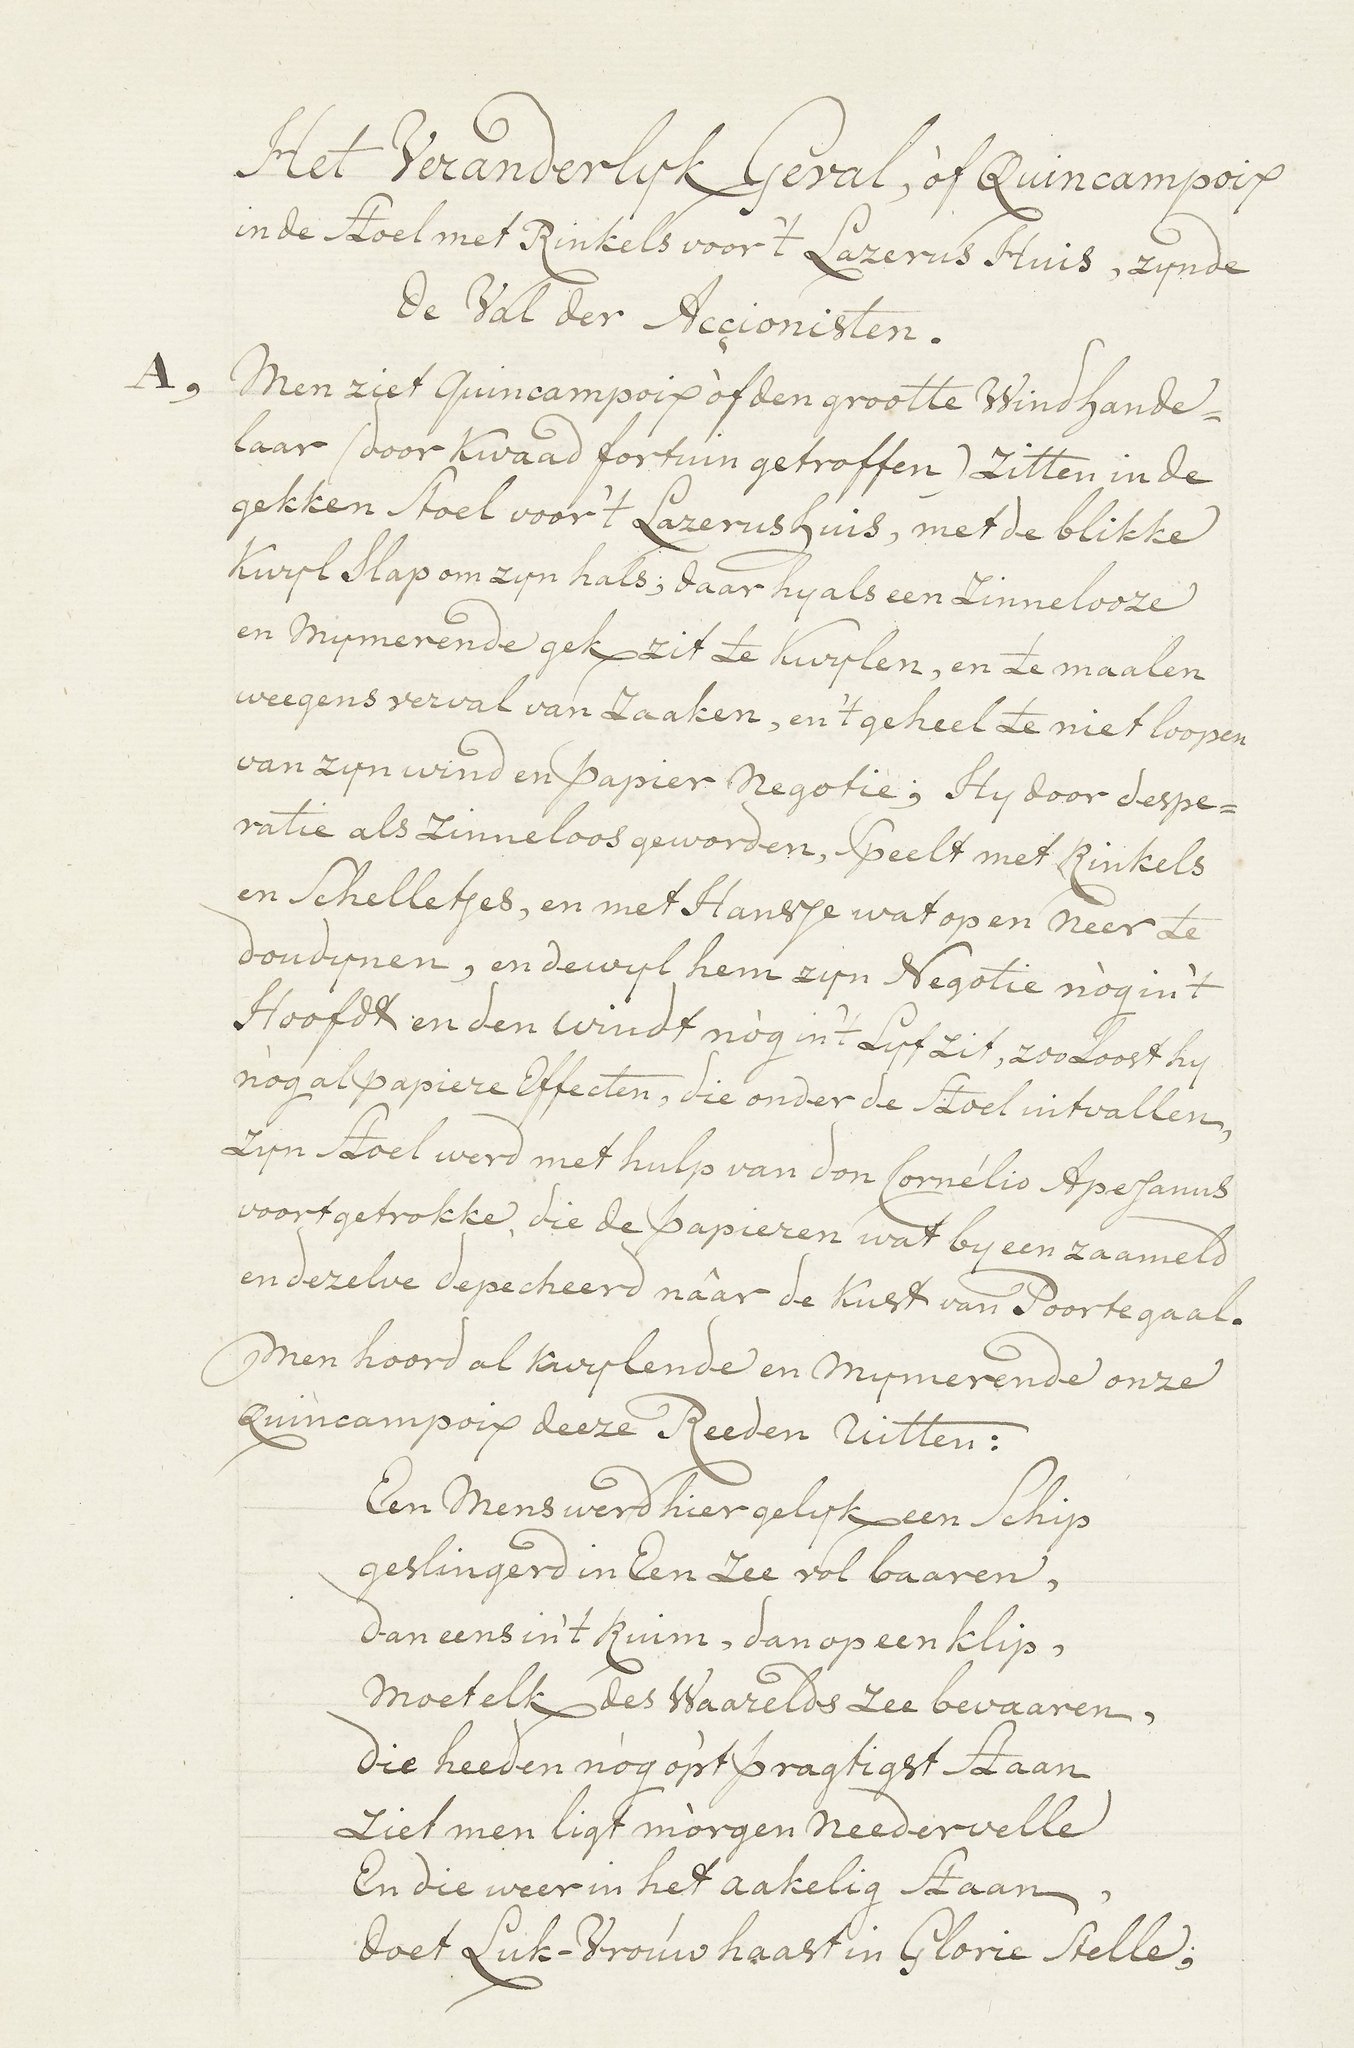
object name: manuscript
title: Het veranderlyk geval, of Quincampoix in de Stoel mer Rinkels voor 't Lazarus Huis, zynde de Val der Accionisten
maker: Anonymous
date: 1720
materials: paper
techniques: writing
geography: northern netherlands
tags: econoom, john law, windhandel van 1720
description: Handgeschreven verklaring van de voorstelling van de tekening Quincampoix in de Stoel mer Rinkels voor 't Lazarus Huis. Vijf dubbelgevouwen bladen en één los blad met een verklaring van de letters A-I. Behoort tot de groep van tekeningen toegevoegd aan de serie Tafereel der Dwaasheid met spotprenten op de Windhandel of Actiehandel van 1720.